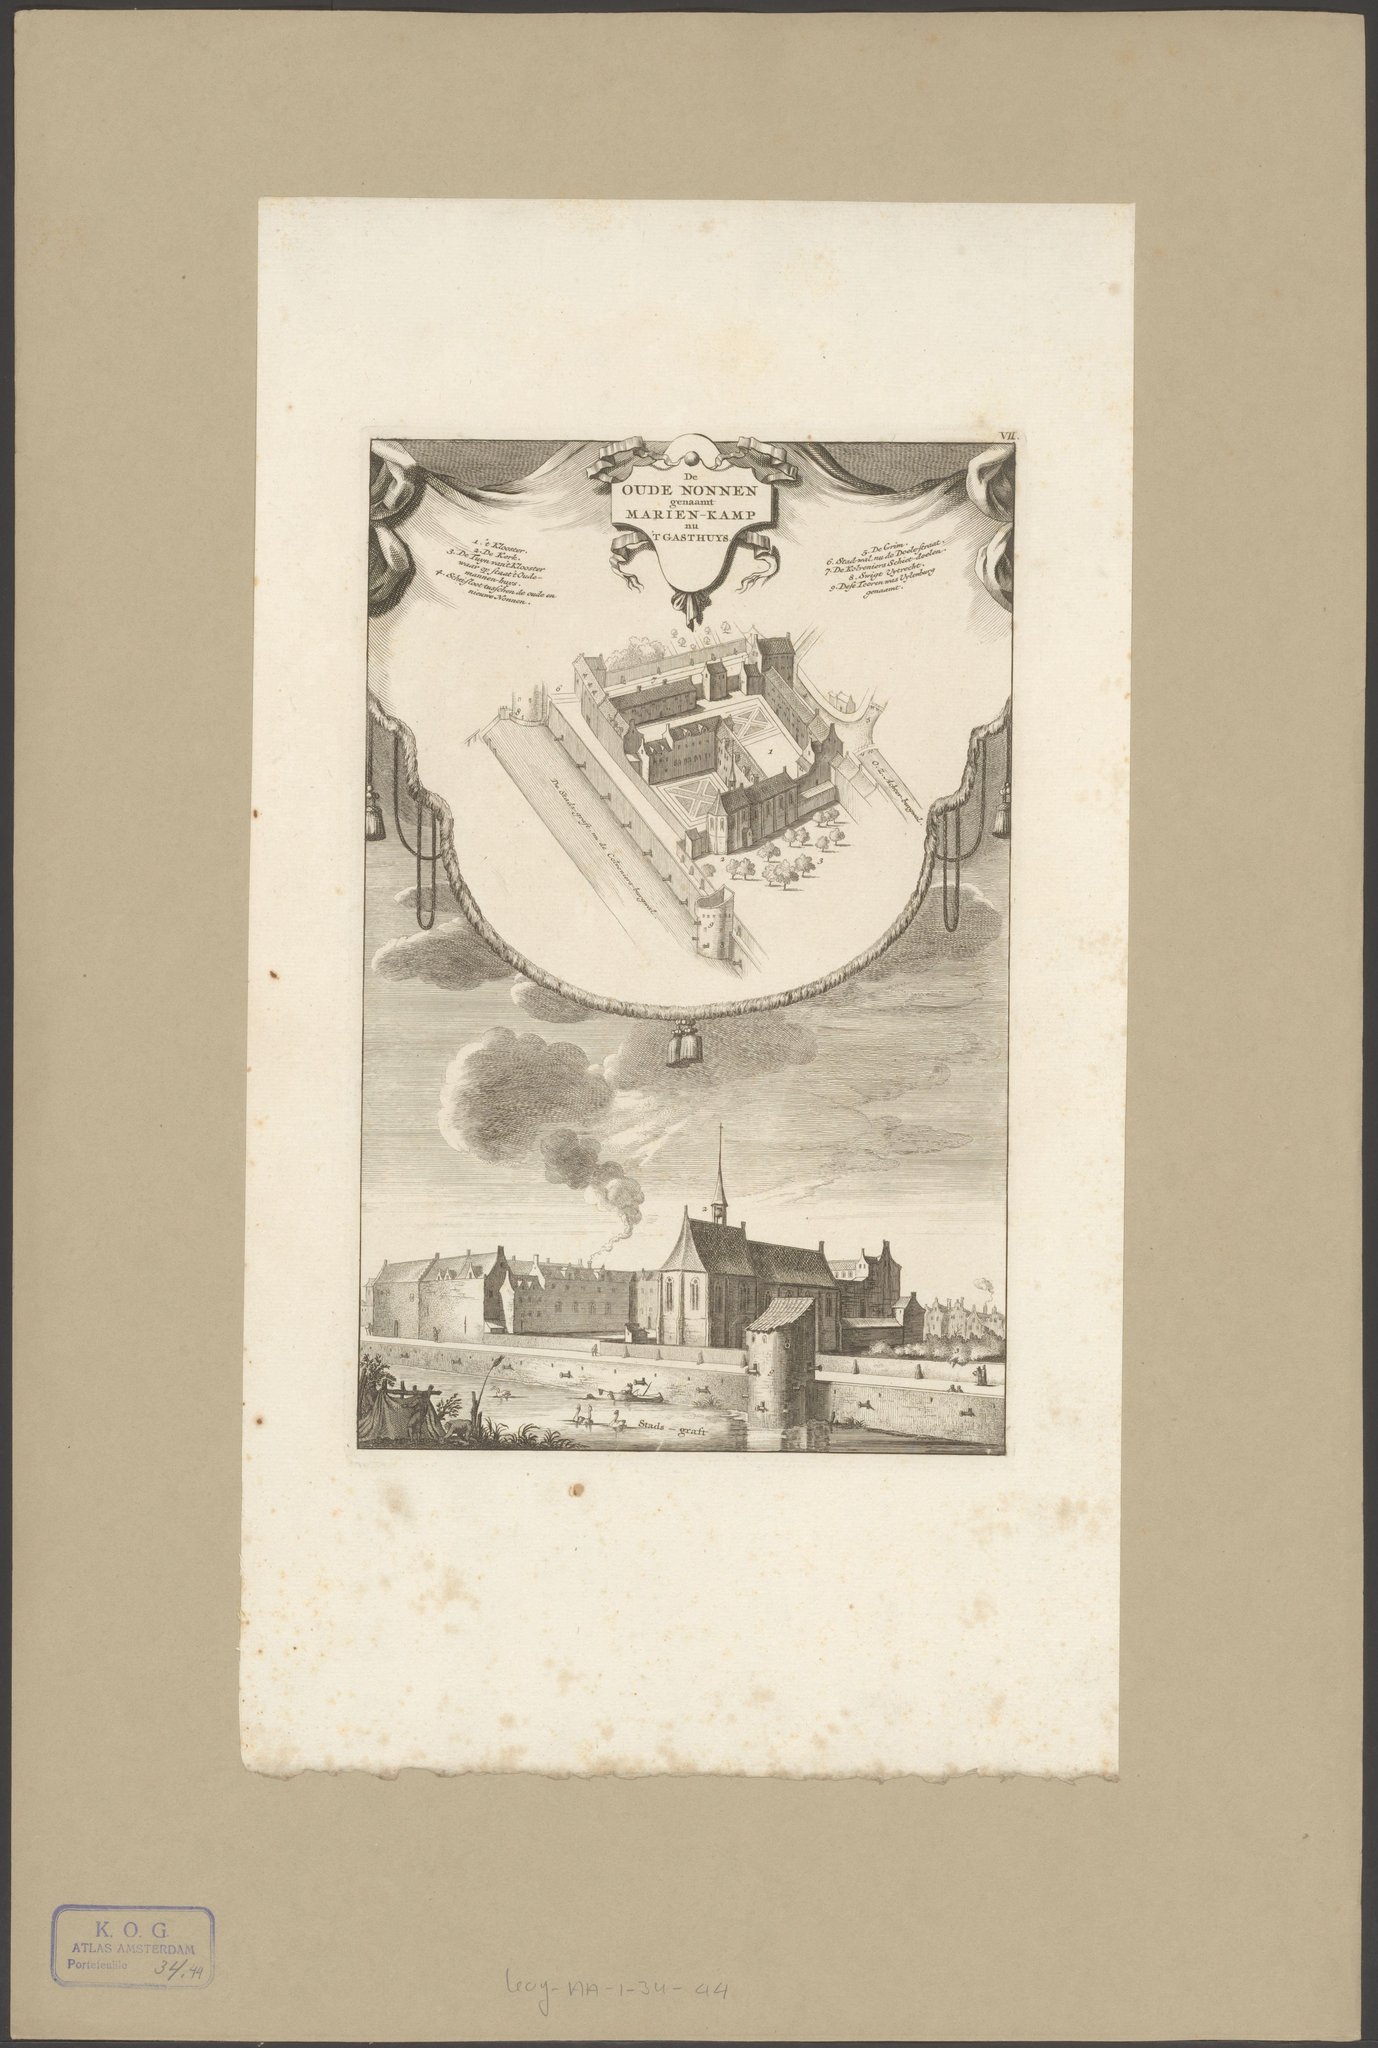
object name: print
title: Gezichten op het Oude Nonnenklooster te Amsterdam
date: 1760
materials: paper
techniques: engraving, etching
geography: amsterdam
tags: abbey, monastery, convent ~ roman catholic church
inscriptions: collector's mark: Lugt 1641b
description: Prent mogelijk uit: Wagenaar, Jan. Amsterdam, in zyne opkomst, aanwas, geschiedenissen (…). Amsterdam: Isaak Tirion, 1760, dl. 1. Dat de prent de situatie rond 1544 weergeeft, gaat terug op het feit dat voor het maken van deze en andere prenten van kloosters en kerken van voor de Alteratie (1578) is uitgegaan van de plattegrond van Cornelis Anthonisz. uit 1544, zie RP-P-OB-70.399 en RP-P-AO-20-15.